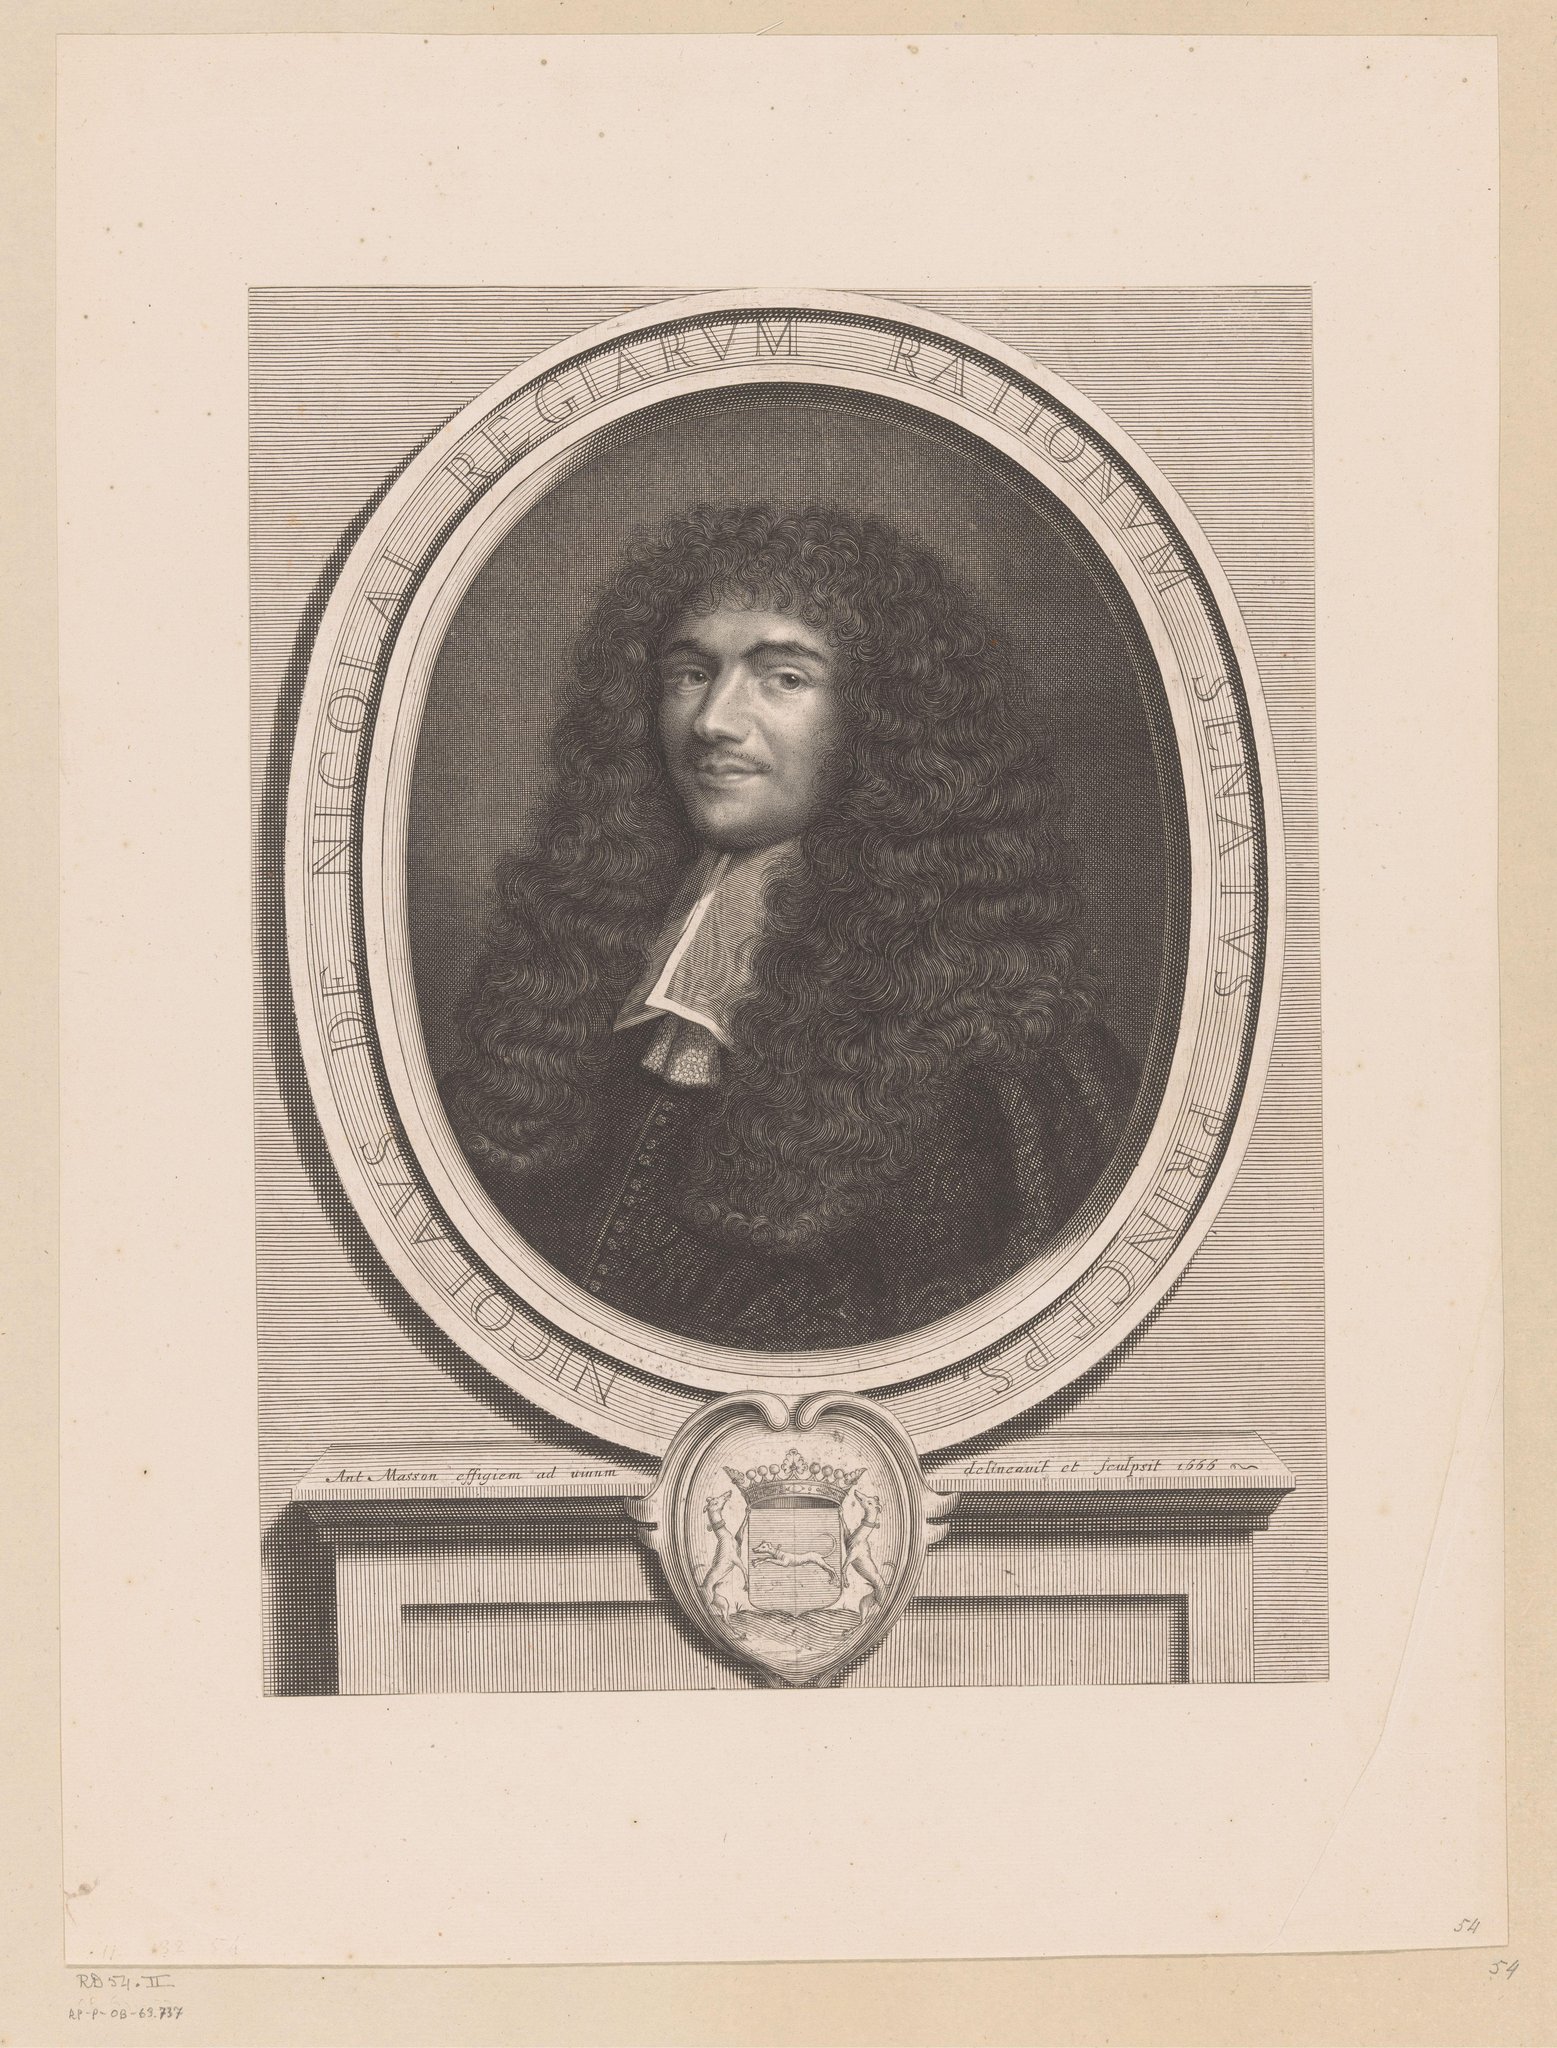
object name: print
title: Portret van Nicolas de Nicolai, markies van Goussainville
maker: antoine masson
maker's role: print maker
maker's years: 1636-1700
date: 1666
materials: paper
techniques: engraving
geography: france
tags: historical persons, armorial bearing, heraldry, nobility and patriciate; chivalry, knighthood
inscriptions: collector's mark: Lugt 240